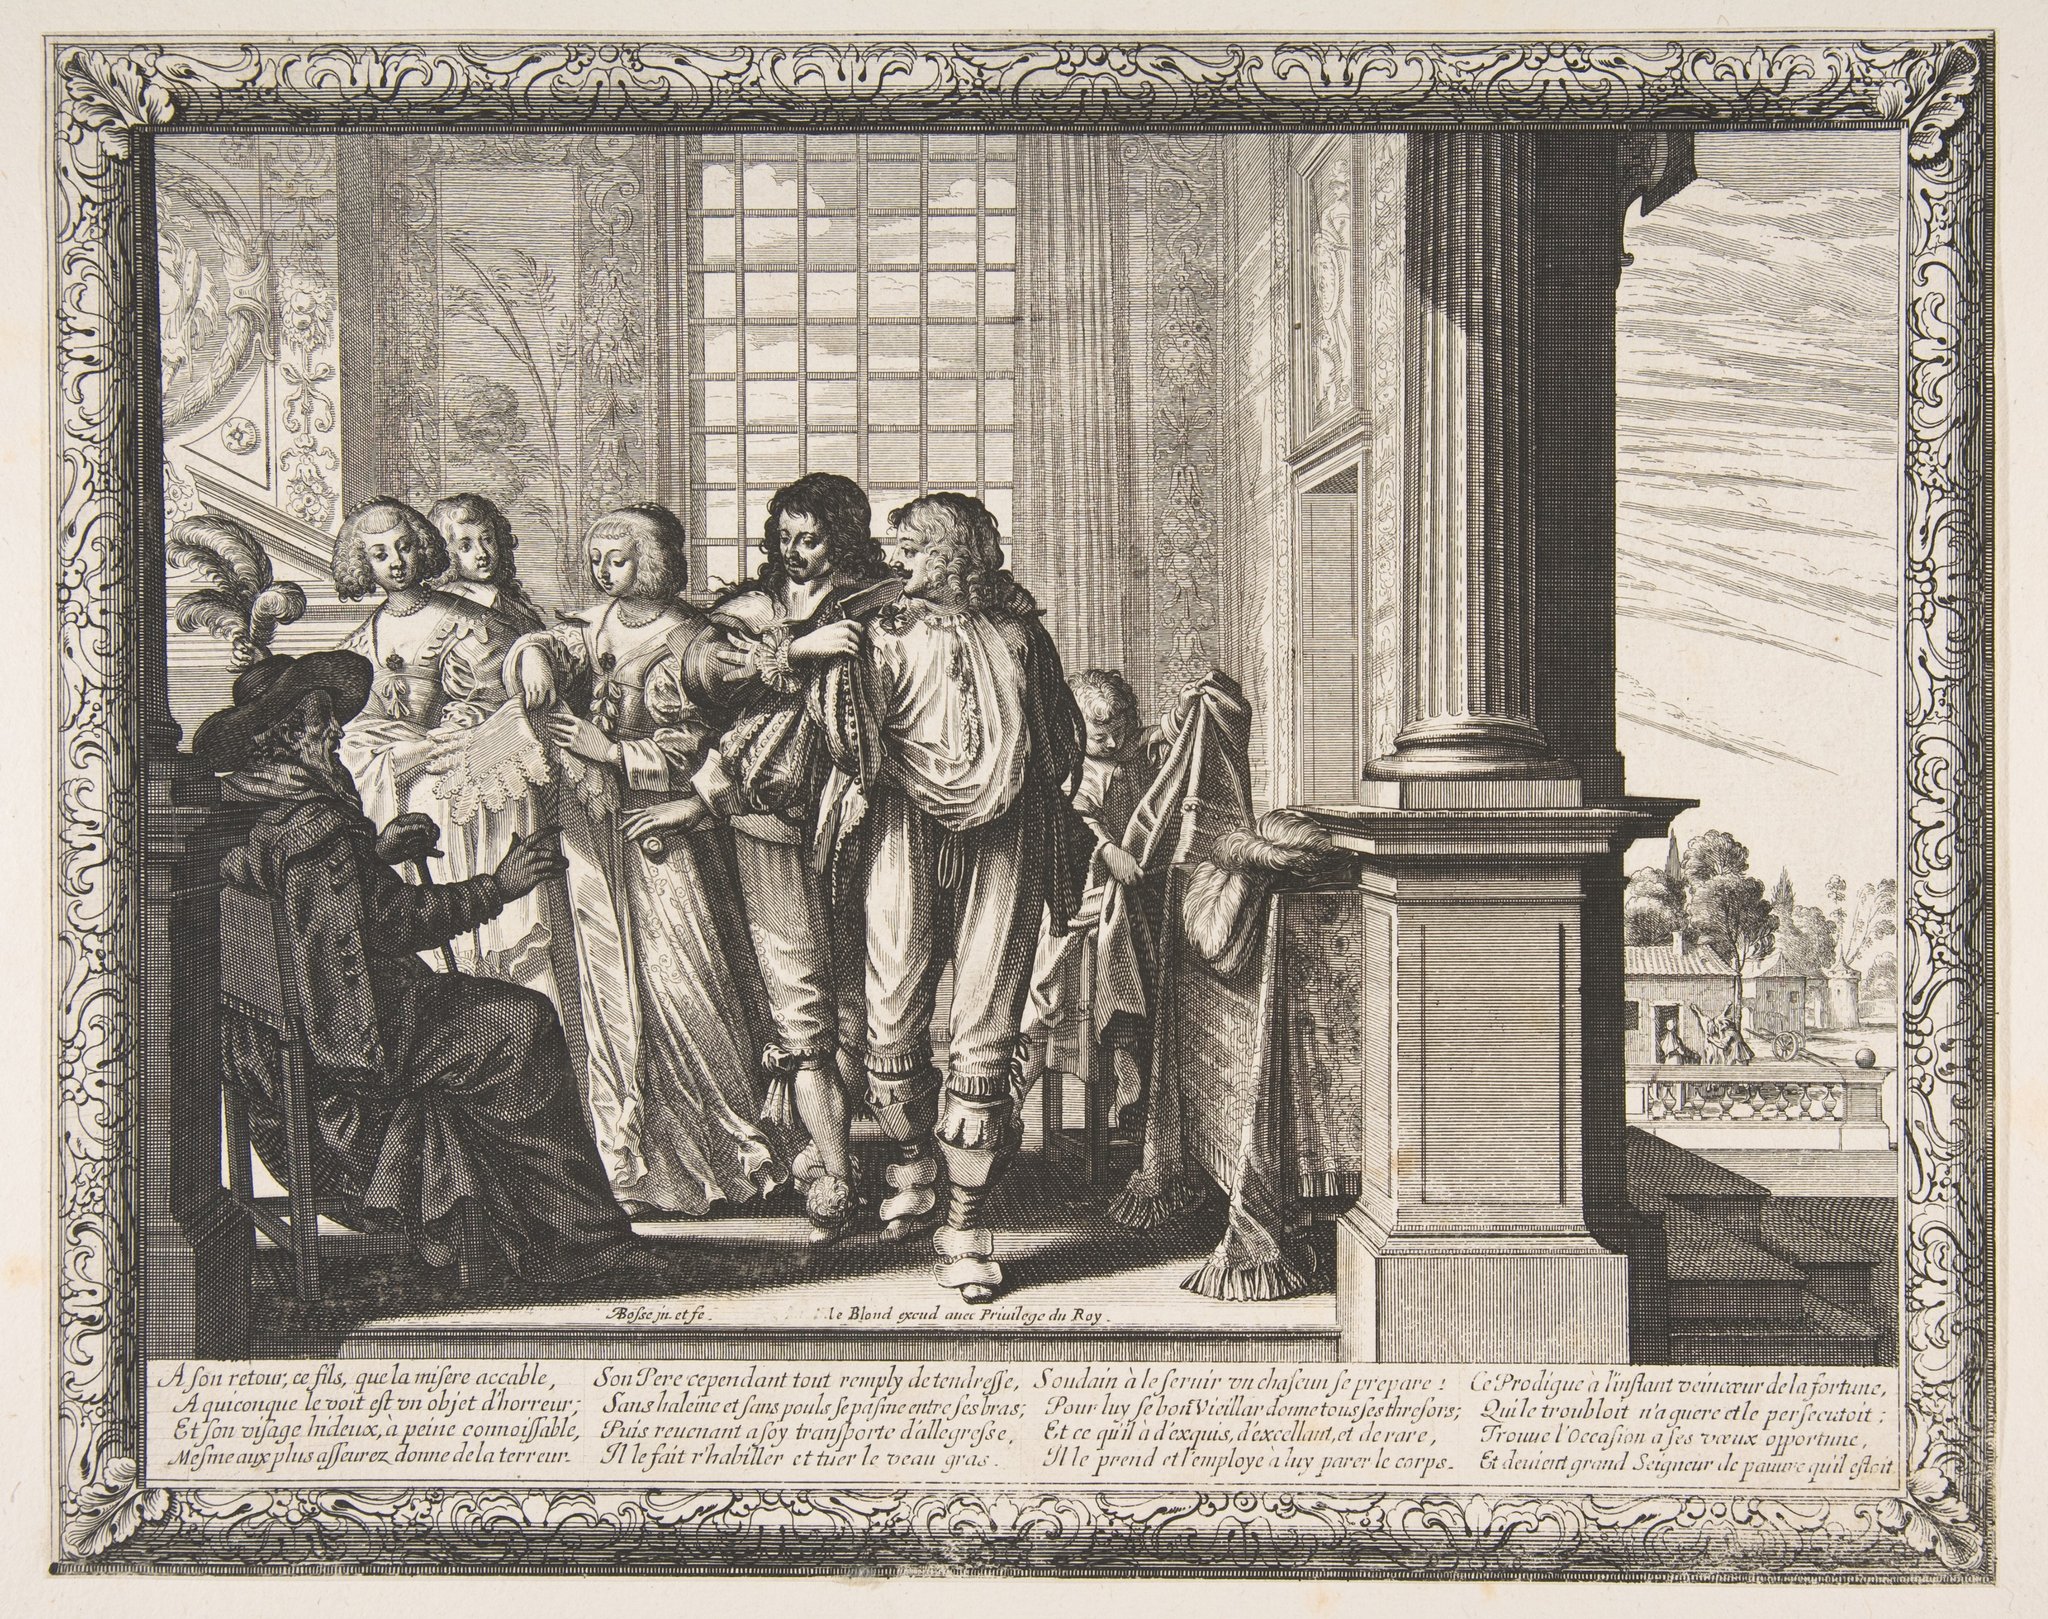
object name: print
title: The Prodigal Son Changes His Clothes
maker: abraham bosse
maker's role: artist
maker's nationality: french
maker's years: 1602-1676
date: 1636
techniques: etching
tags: men,women,dressing